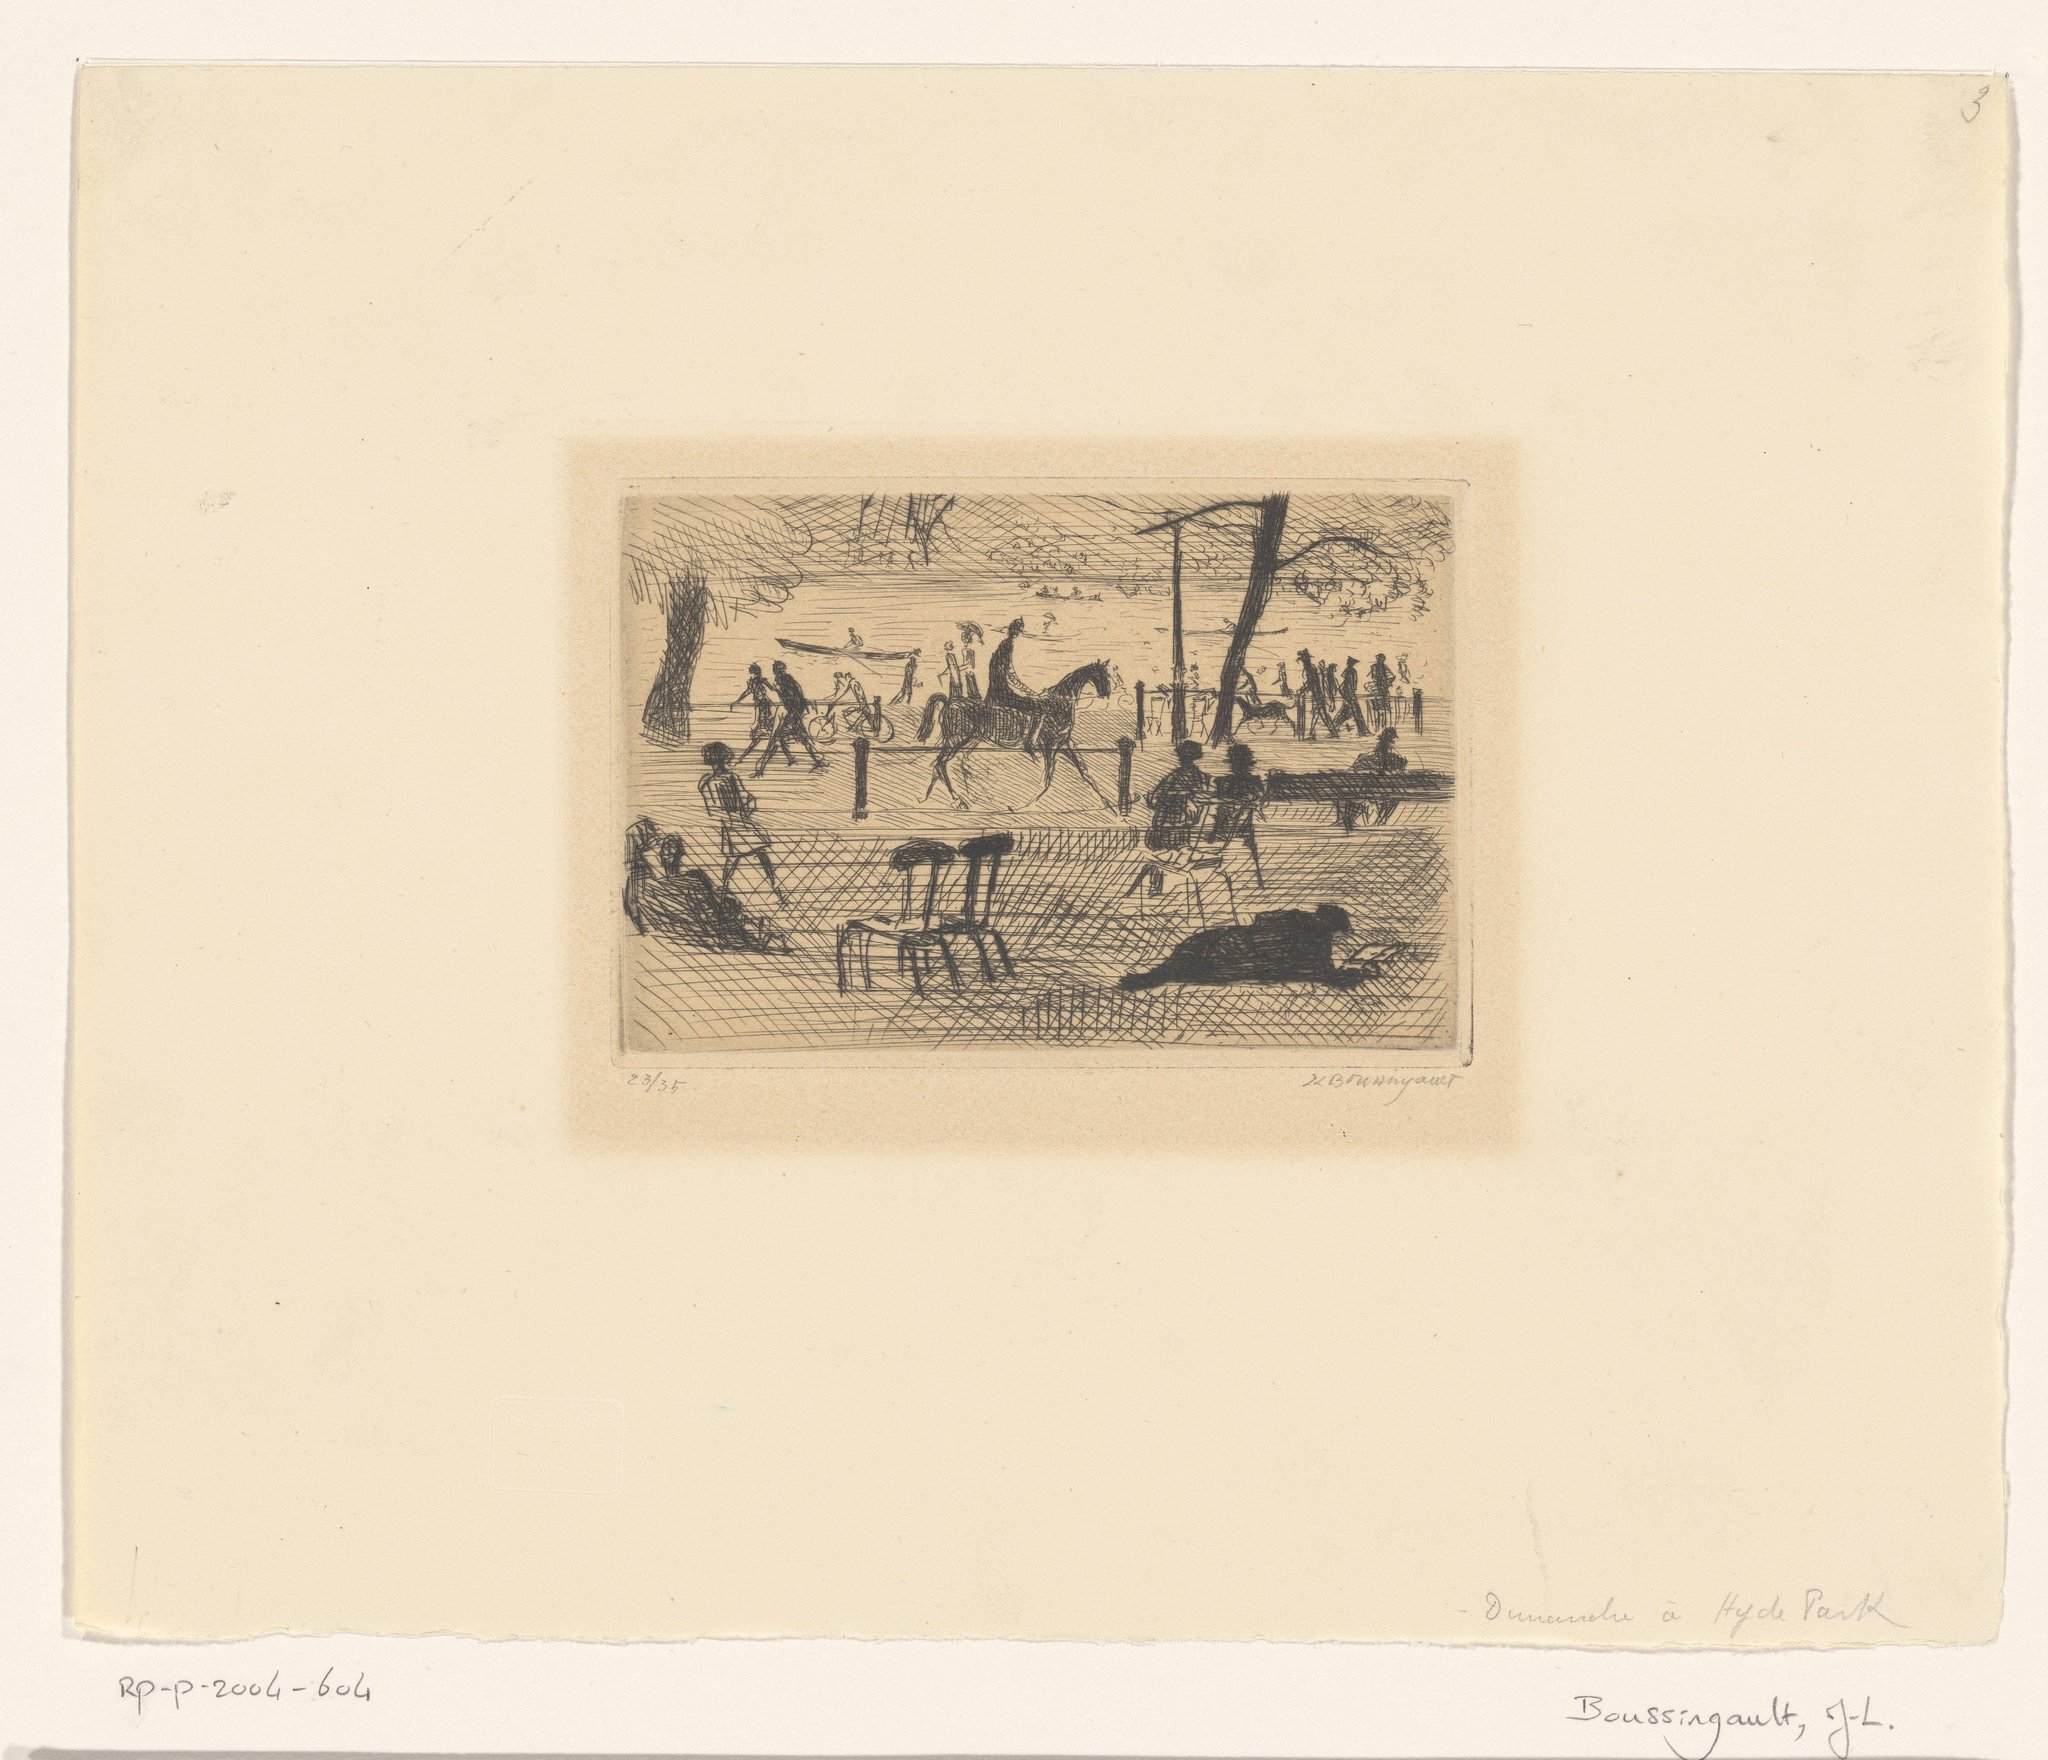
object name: print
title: Dimanche à Hyde Park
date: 1910-1943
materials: paper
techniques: etching, intaglio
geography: paris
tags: park, public gardens, park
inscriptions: collector's mark: Lugt 2228, check stamp: ‘Jacquart/ Éditeur/ Paris’